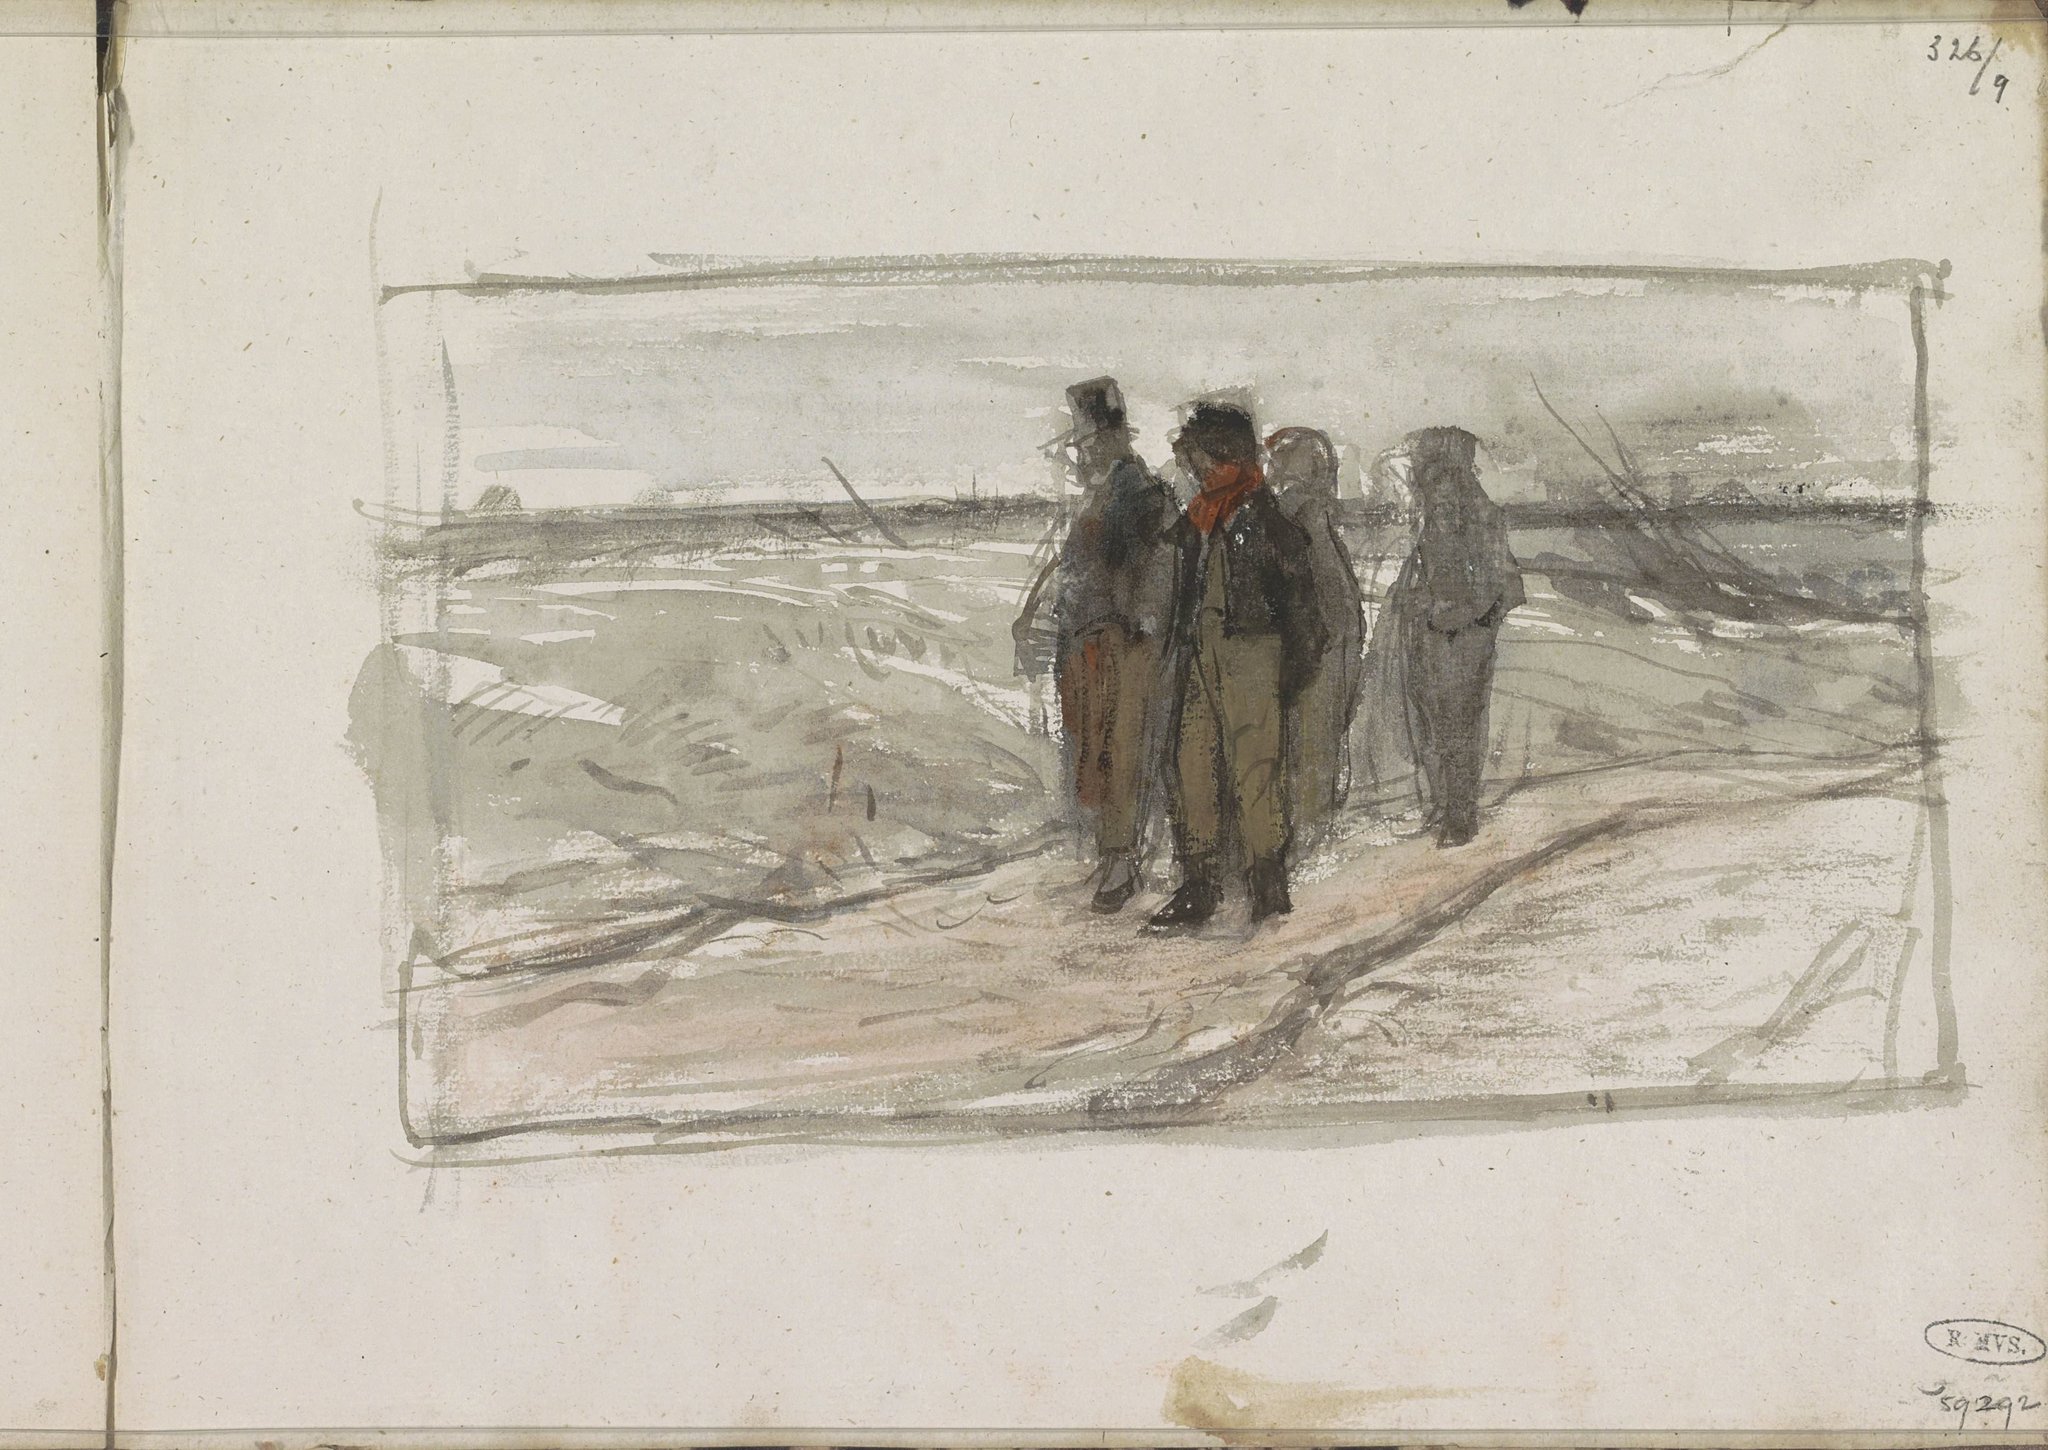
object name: sketchbook leaf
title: Vier mannen op een pad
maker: anton mauve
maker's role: draughtsman, painter, print maker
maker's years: 1838-1888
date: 1848-1888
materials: paper, watercolor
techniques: brush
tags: landscapes (+ landscape with figures, staffage)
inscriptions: collector's mark: Lugt 2228a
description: De figuren kijken uit over het landschap. Achterste schutblad uit een schetsboek met 34 bladen.